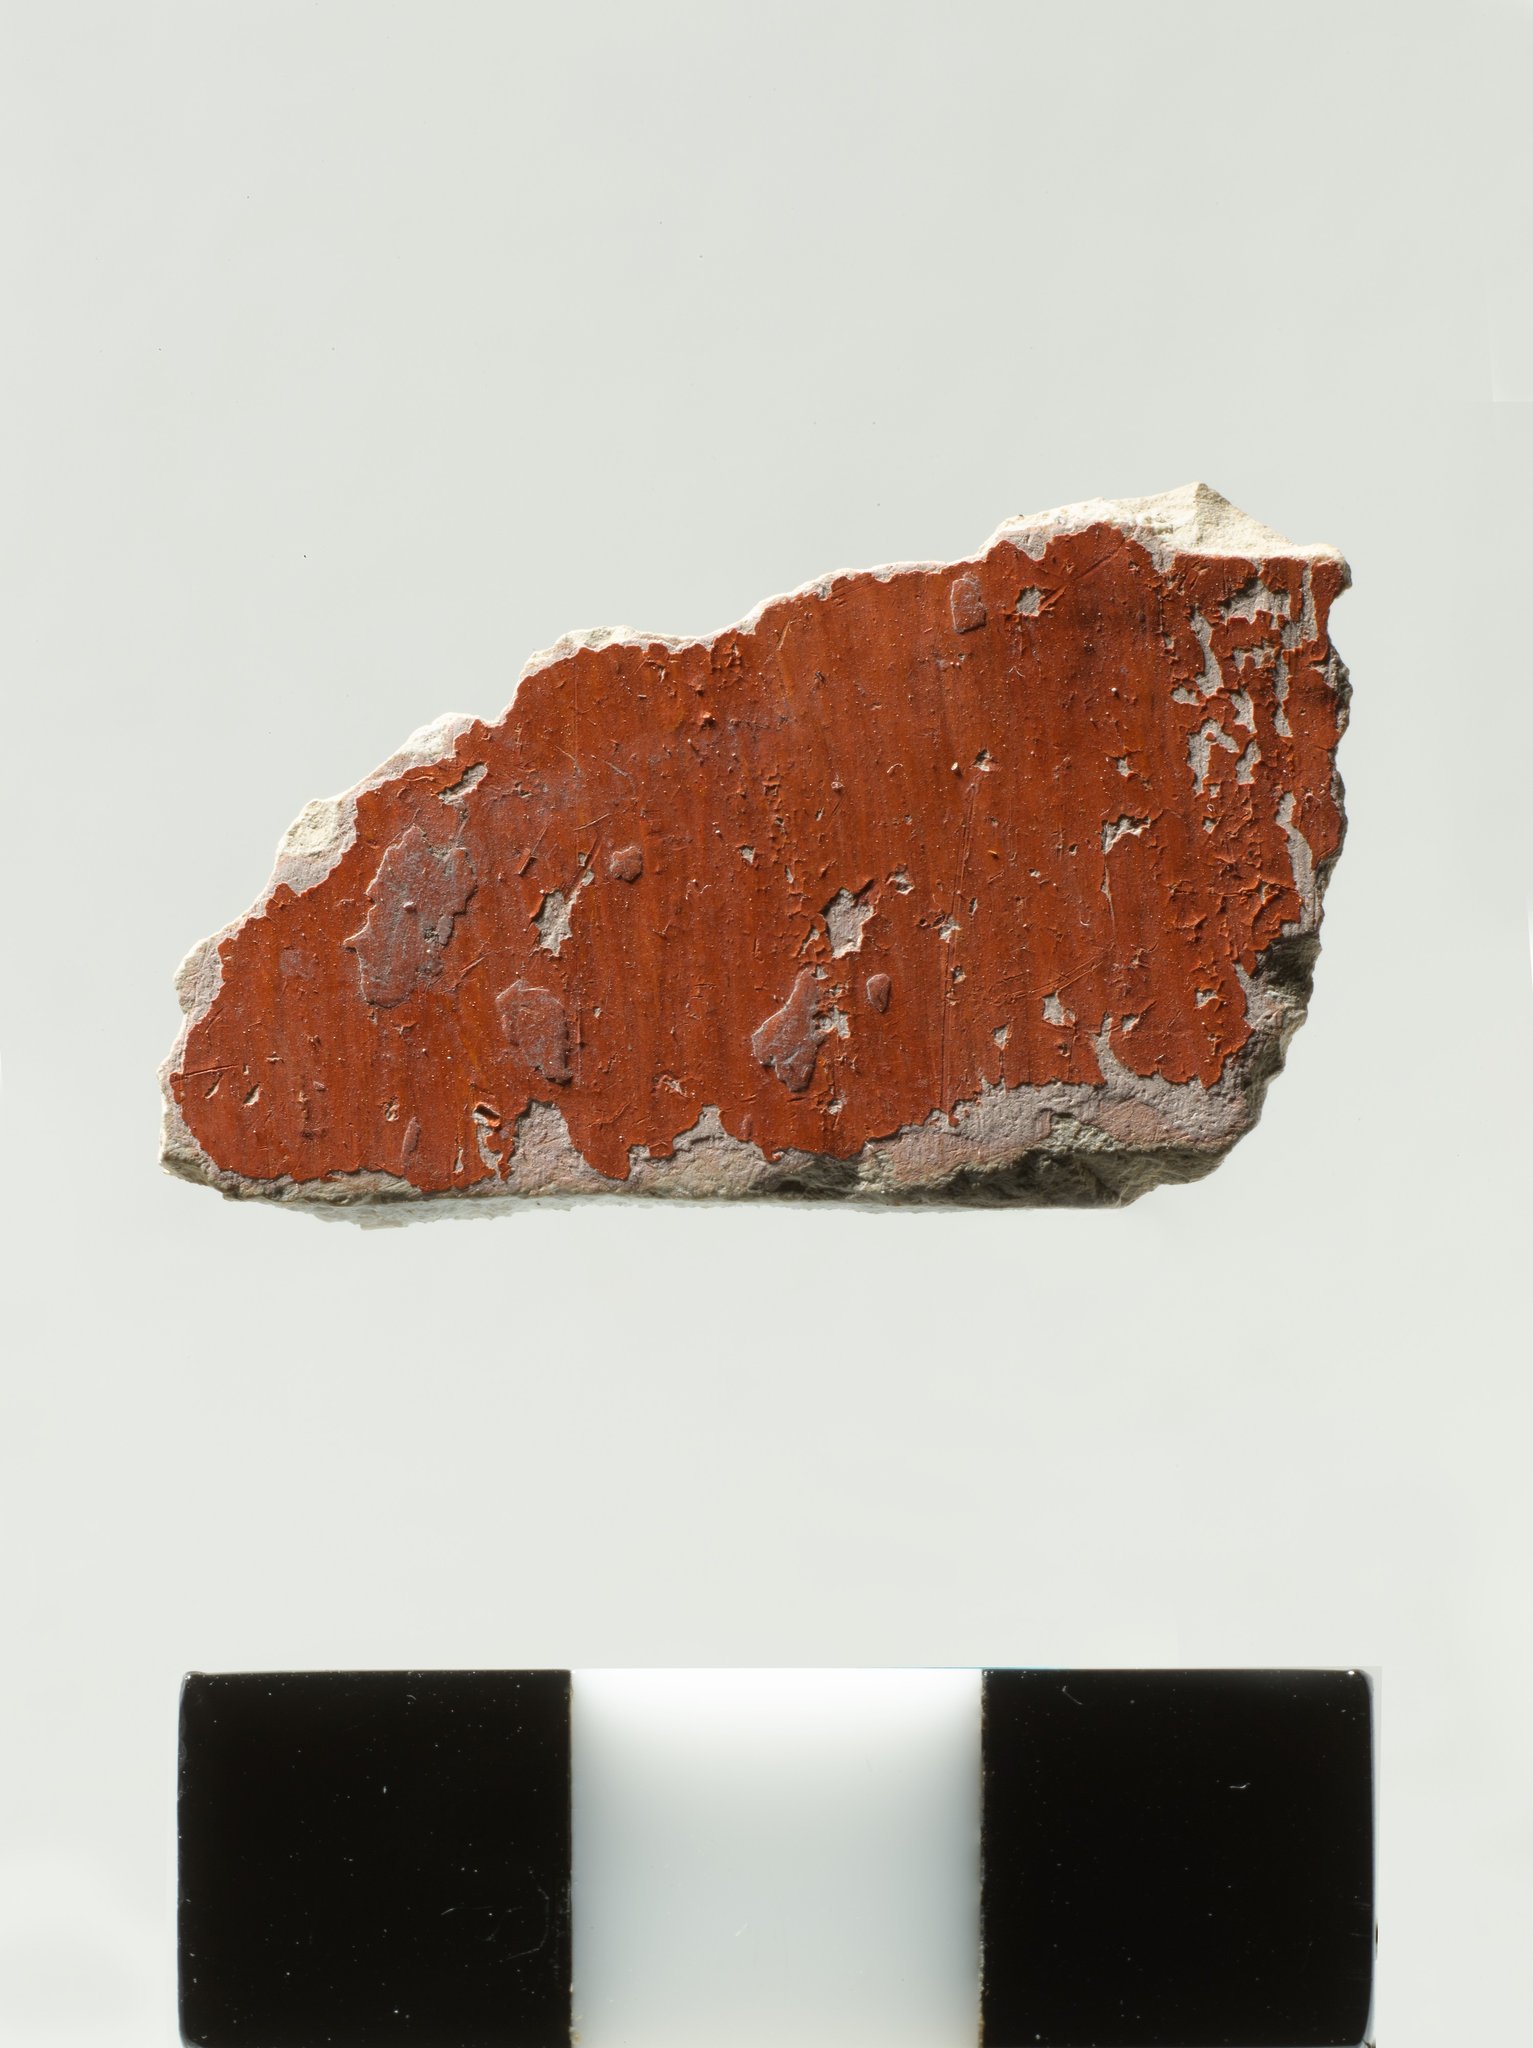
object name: relief fragment, tomb of meketre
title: Reliefs from the tomb of Meketre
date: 1981-1975 BCE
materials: limestone, paint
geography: egypt